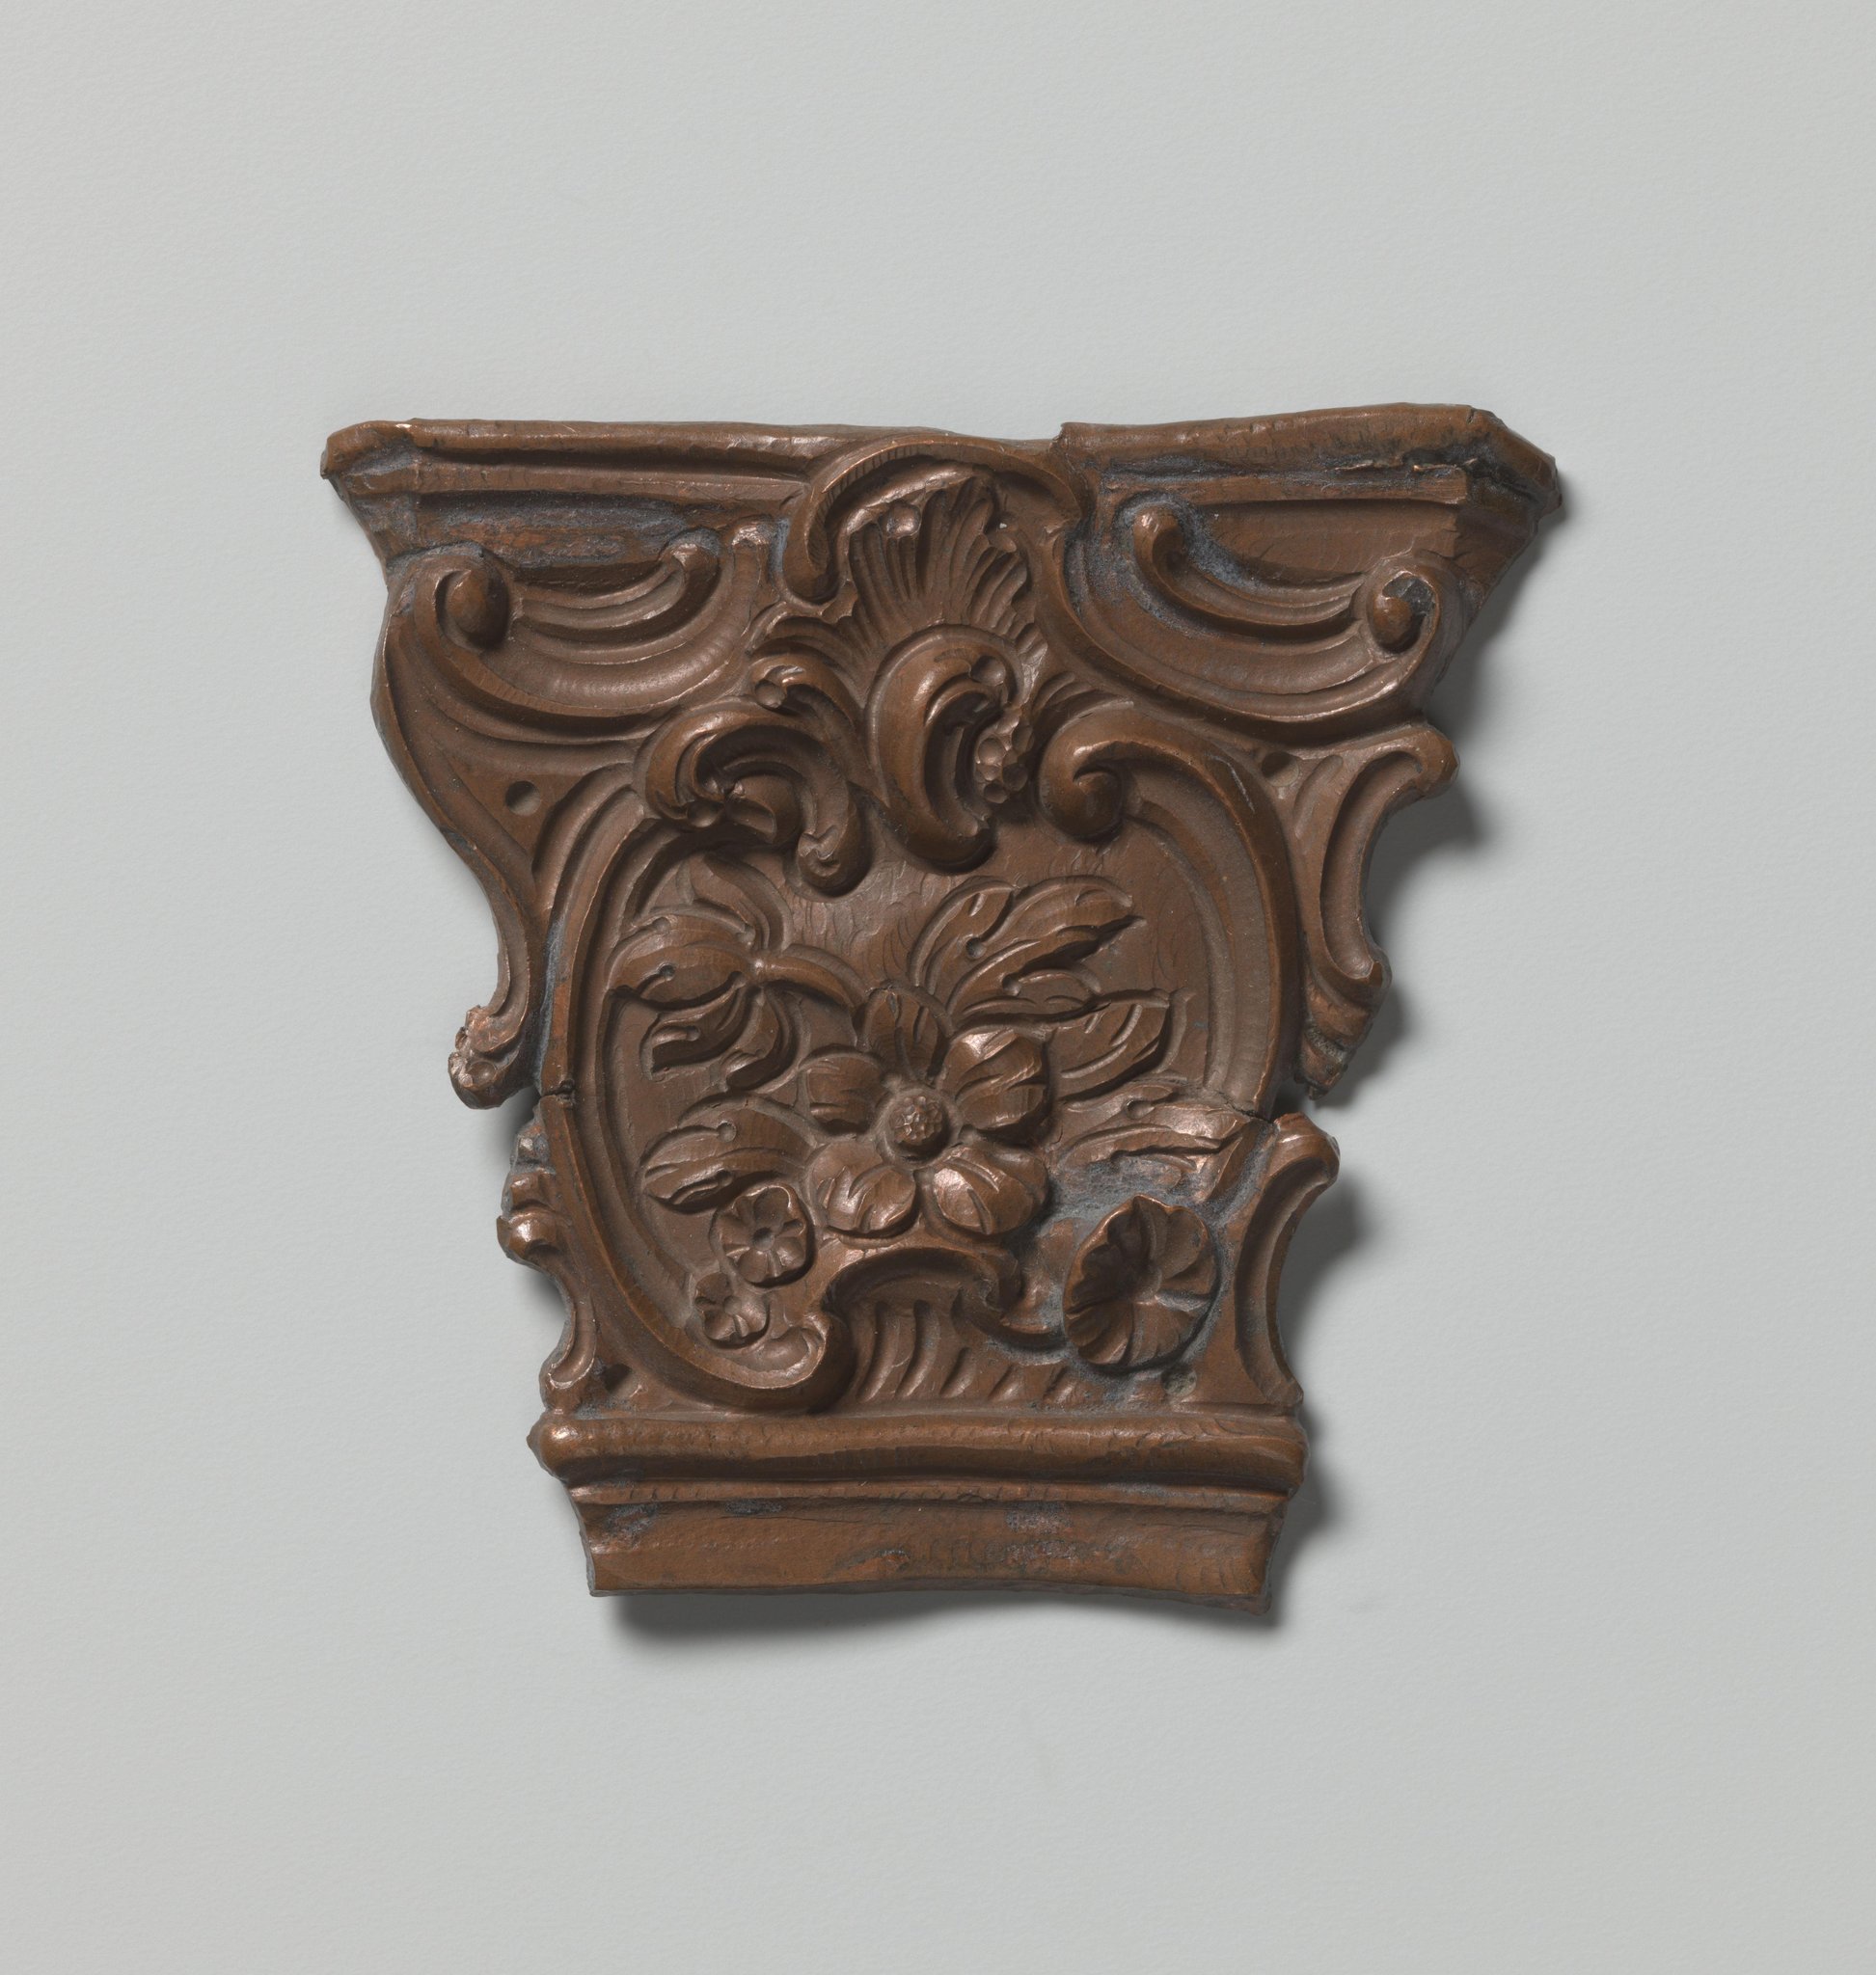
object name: model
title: Model voor een klamp van een boekslot in de vorm van een kapiteel met bloemmotieven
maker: Anonymous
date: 1750-1775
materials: copper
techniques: metalworking, cutting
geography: amsterdam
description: Model van roodkoper voor een gietvorm van een klamp van een boekslot. De voorstelling toont bloemen in een rococo-ornament, gevormd door twee grote, naar binnen gekeerde c-voluten. Daarboven een schelpvorm. De boven- en onderzijde zijn recht.